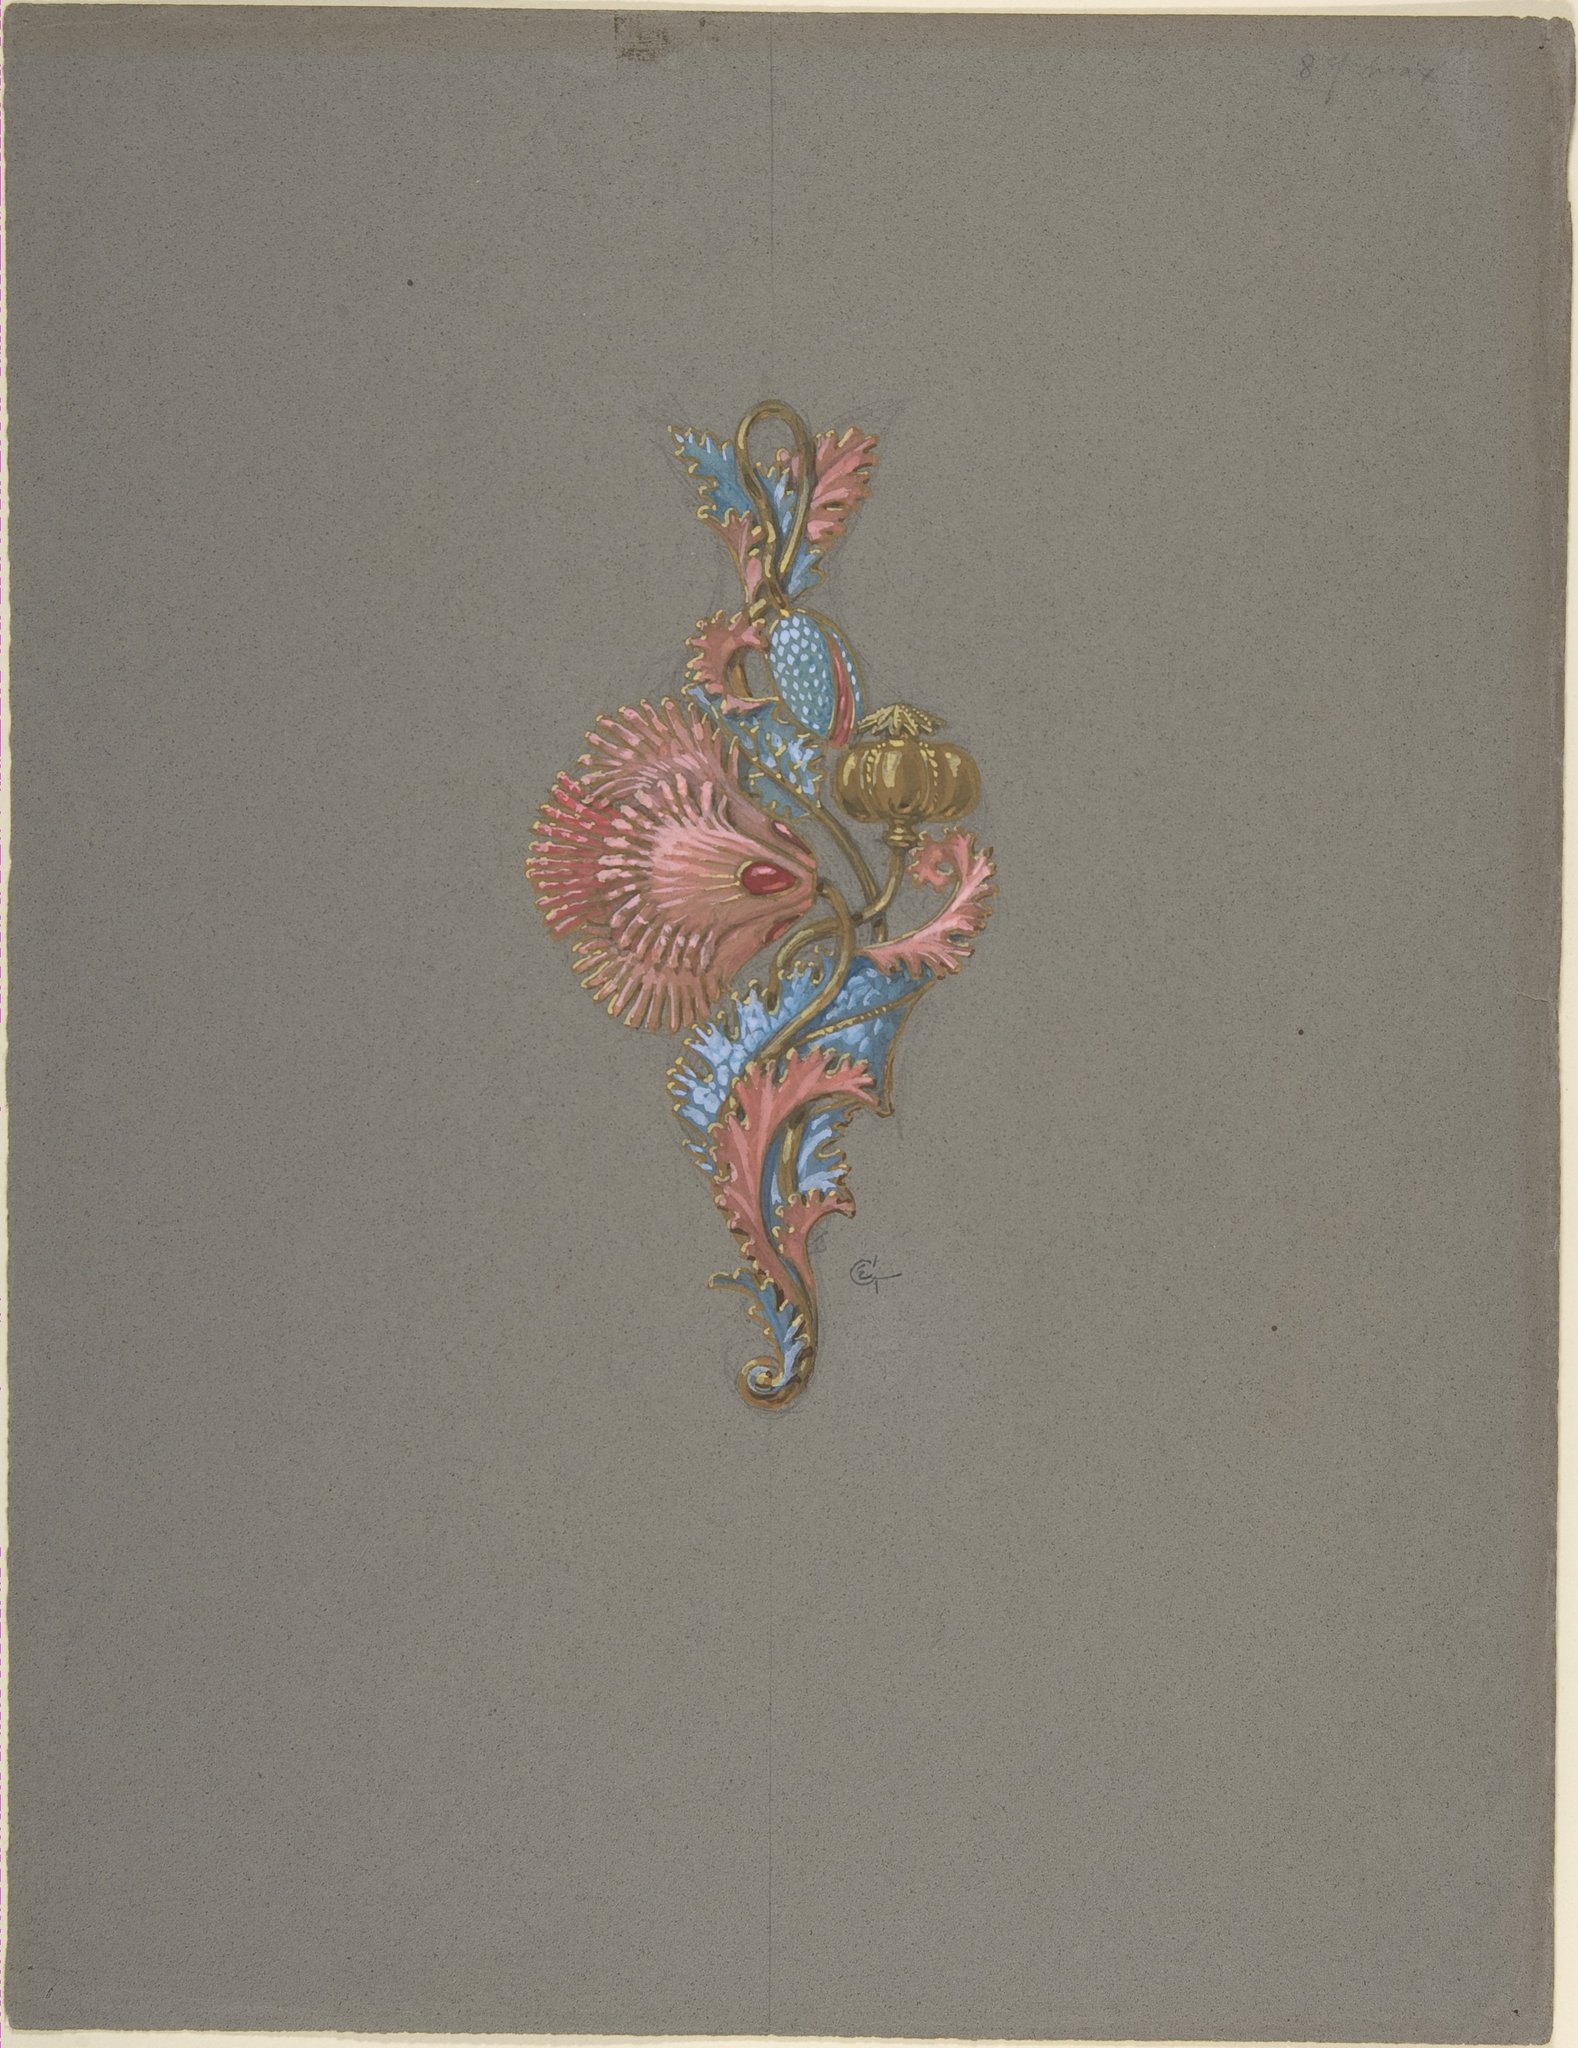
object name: album print ornament architecture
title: Design for a Pendant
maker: eugène-samuel grasset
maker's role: artist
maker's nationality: french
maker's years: 1841-1917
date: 1841-1917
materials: gouache, paper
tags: pendants